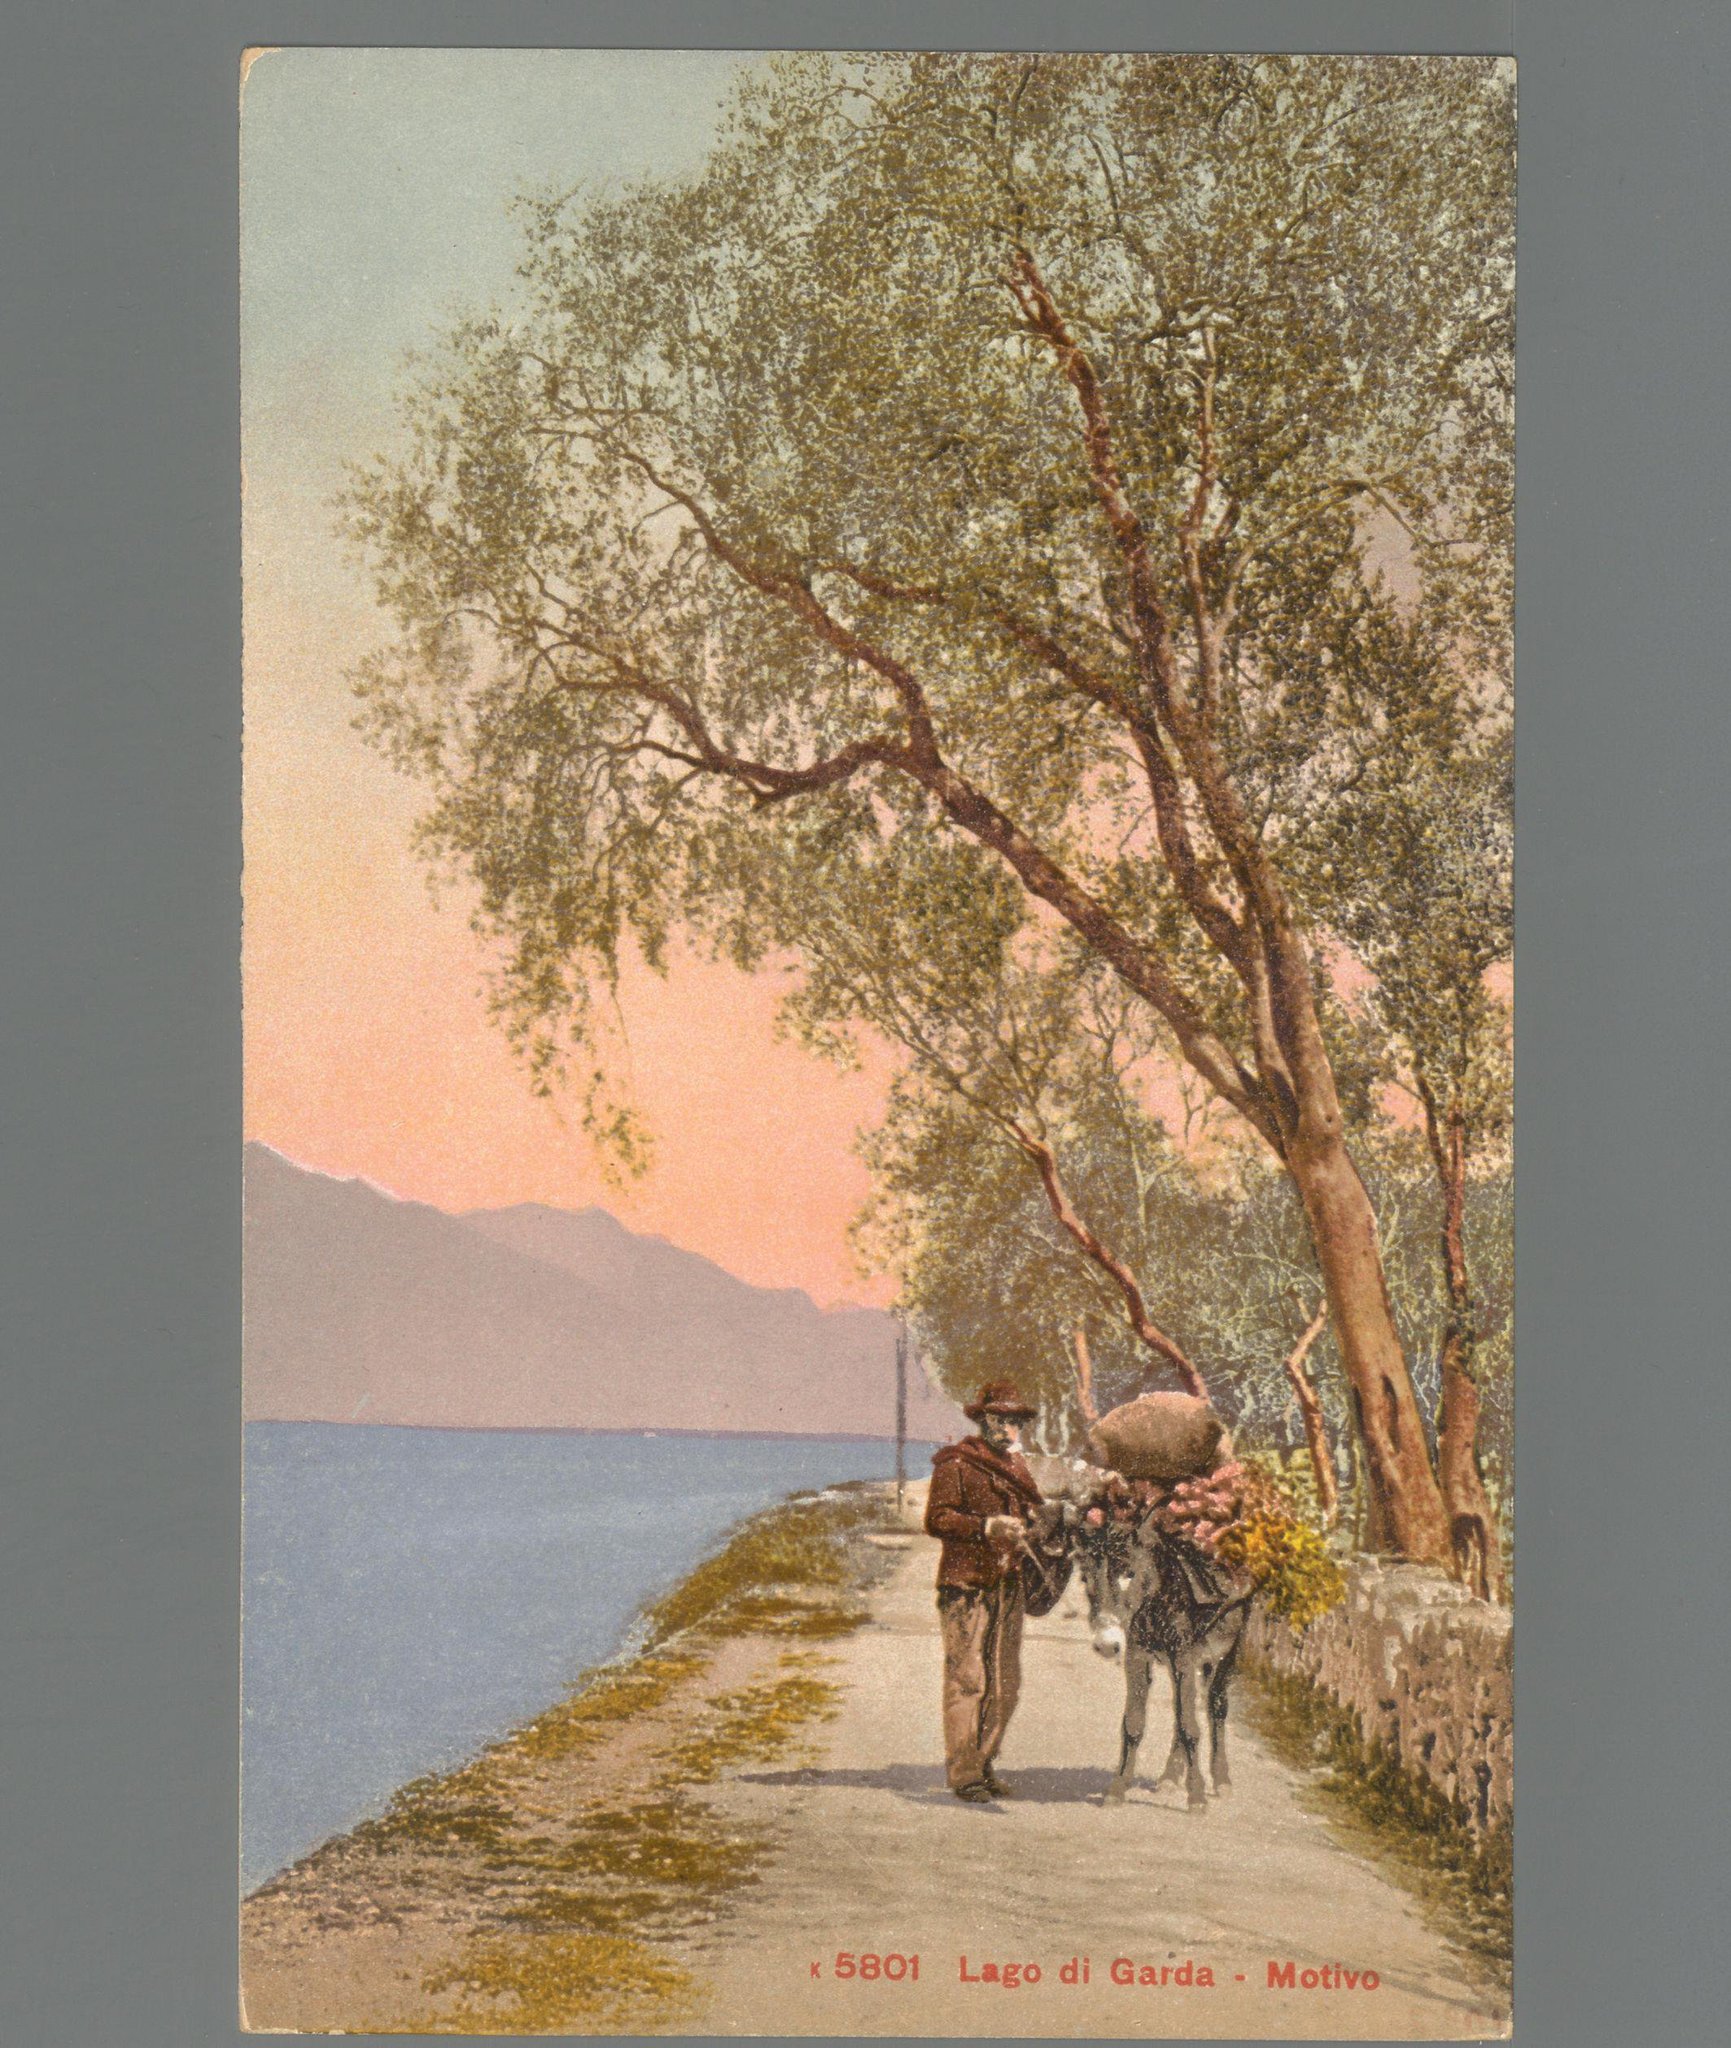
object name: photomechanical print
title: Lago di Garda. Motivo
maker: Anonymous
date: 1905-1930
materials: cardboard, photographic process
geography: zurich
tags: ass, donkey, adult man, lake